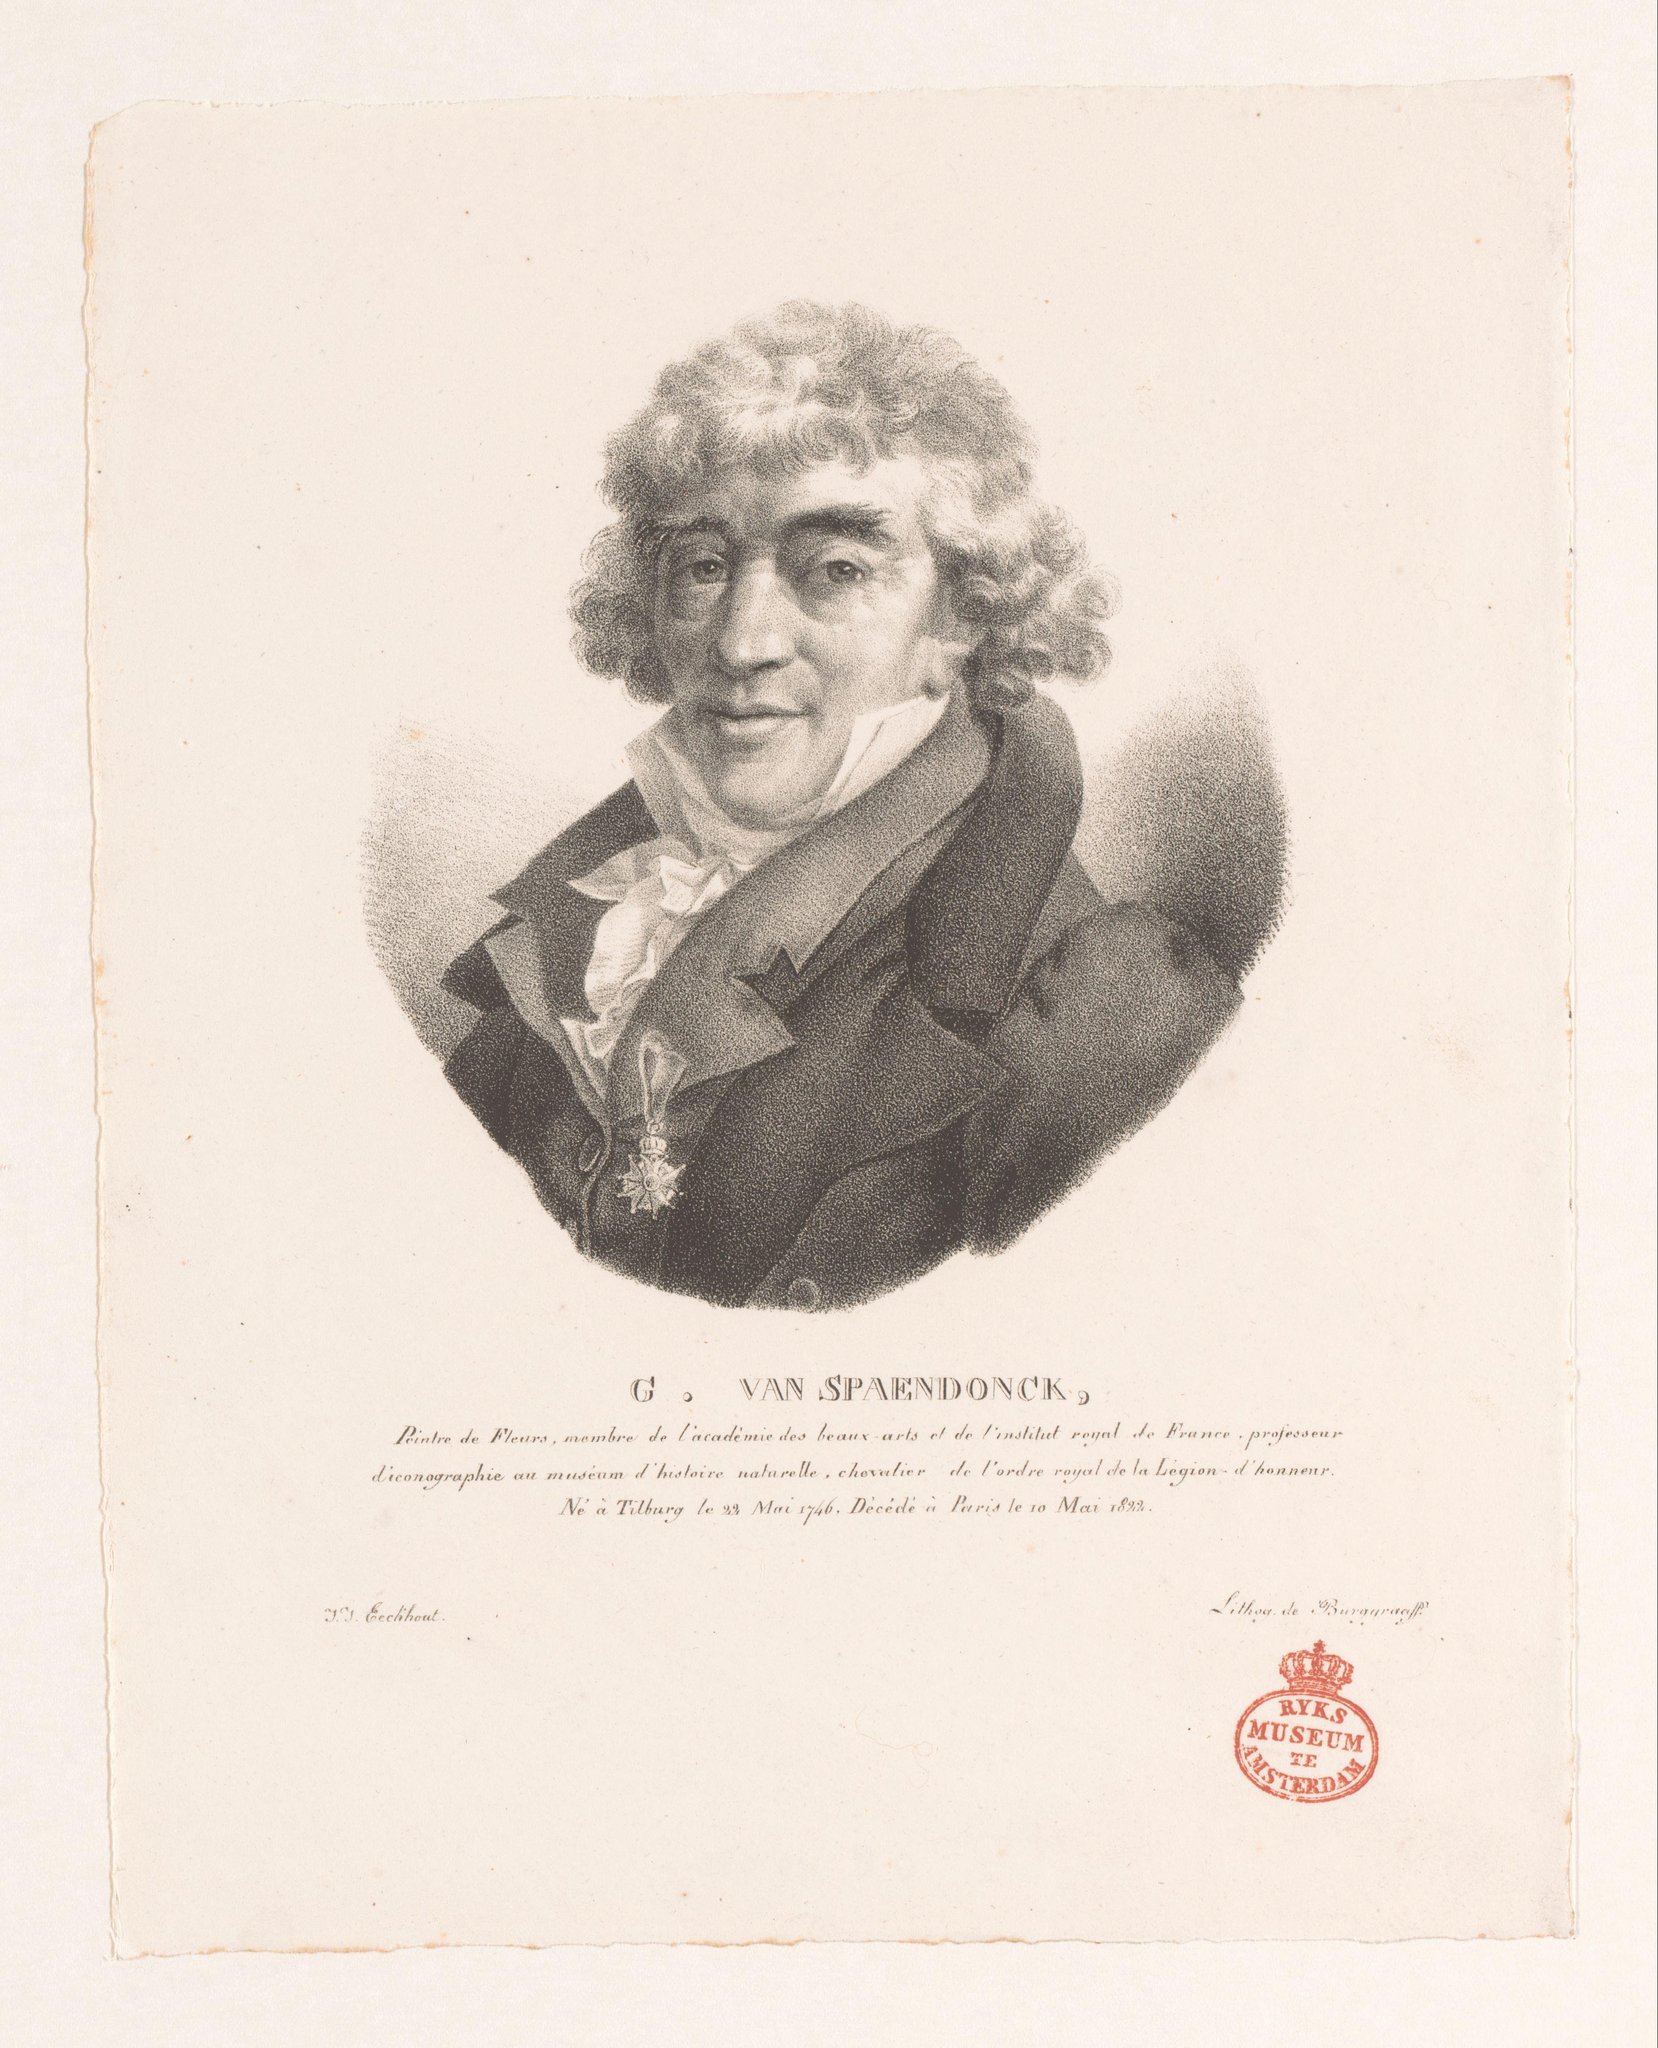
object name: print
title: G. van Spaendonck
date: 1822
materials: paper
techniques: lithograph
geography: brussels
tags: paris, print maker, draughtsman, gerard van spaendonck, historical persons, portrait, self-portrait of painter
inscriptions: collector's mark: Lugt 12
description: Prent maakt deel uit van een serie van zestig prenten.